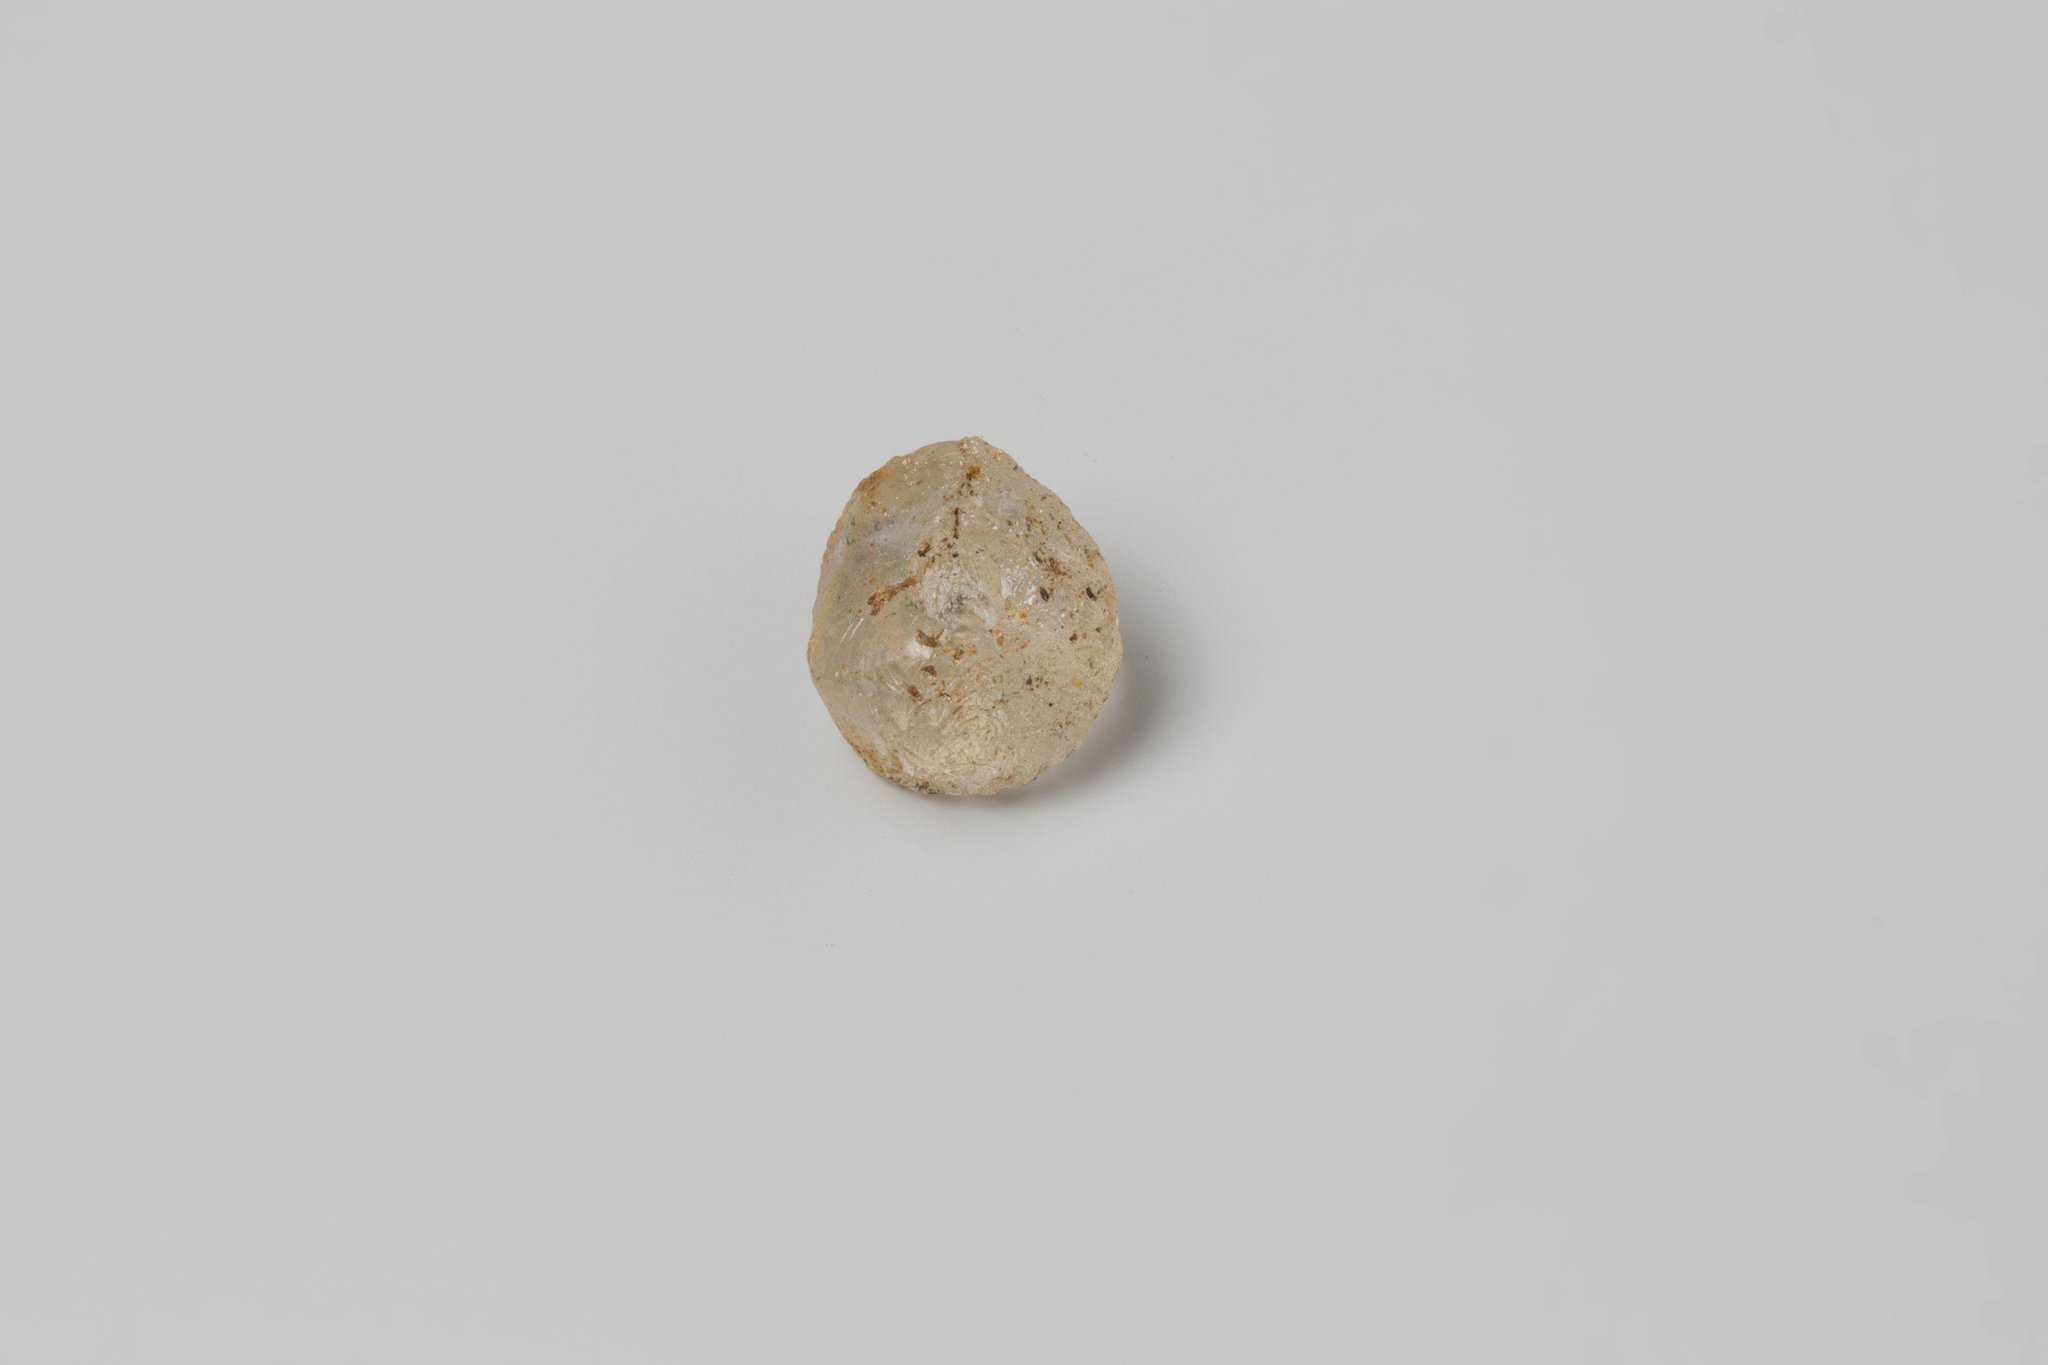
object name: drinking glass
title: Fragment rechte steel van glas uit het wrak van de Oost-Indiëvaarder Hollandia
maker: Anonymous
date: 1700-1743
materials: glass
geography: netherlands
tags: verenigde oostindische compagnie, hollandia (schip), annet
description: Glass, stem glass, stems, plain; fragm, circular, hollow core, eroded.